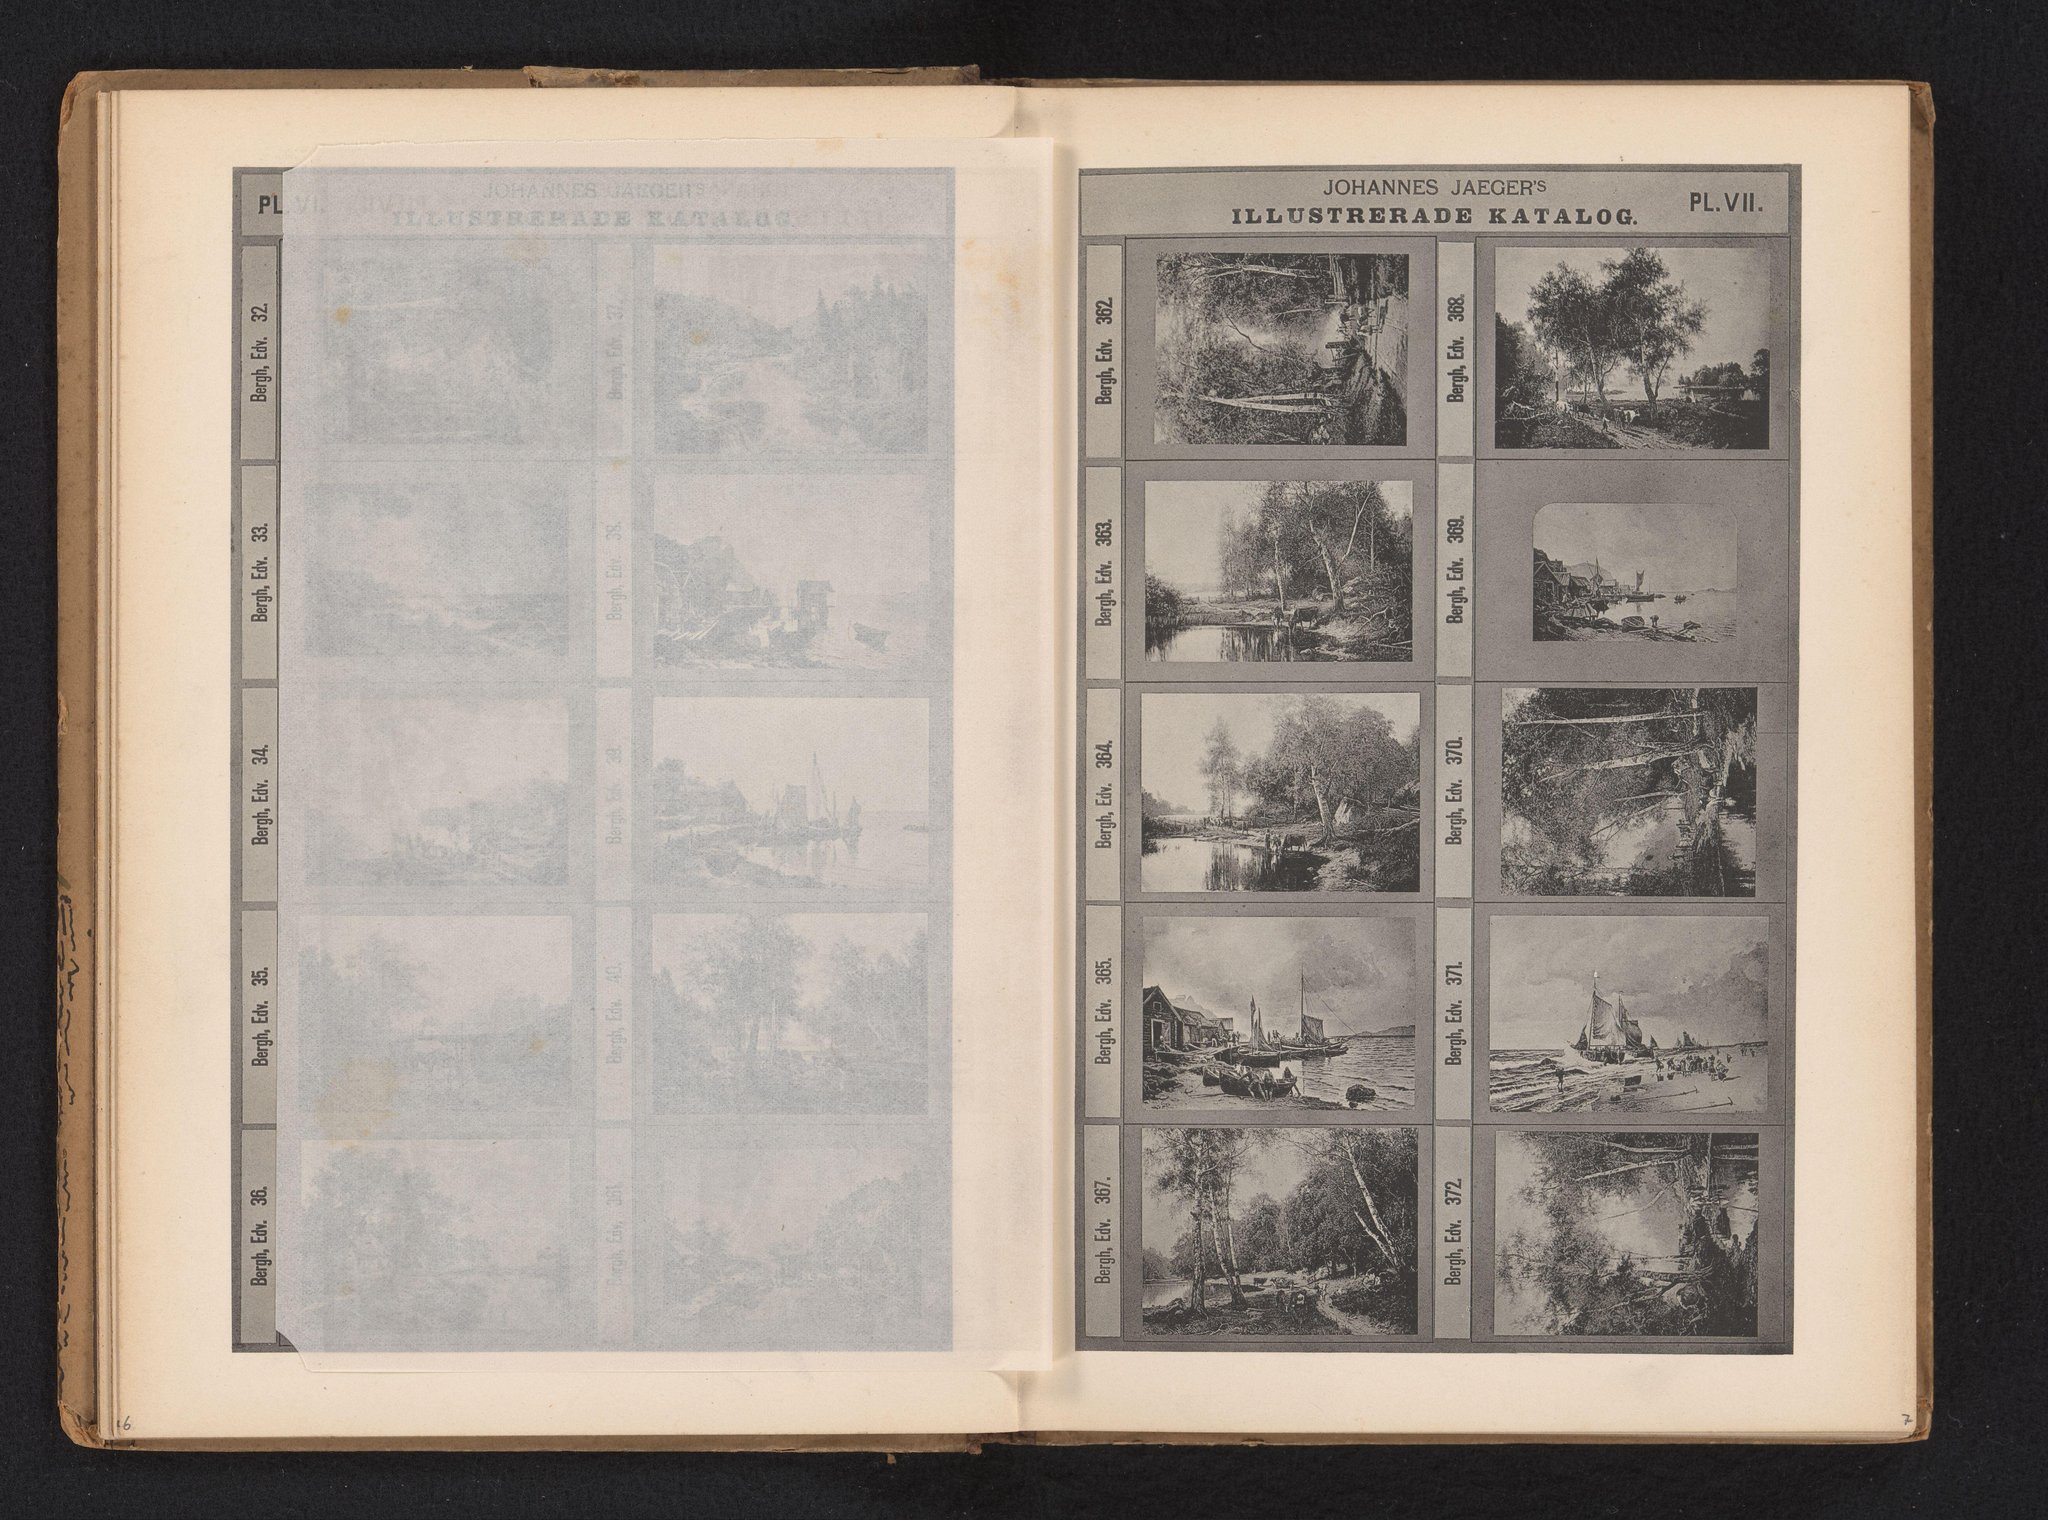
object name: photomechanical print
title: Johannes Jaeger's Illustrerade Katalog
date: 1872-1882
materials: paper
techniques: photograph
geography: stockholm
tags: landscapes, picture, painting, traffic on the water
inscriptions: number: ‘PL. VII.’